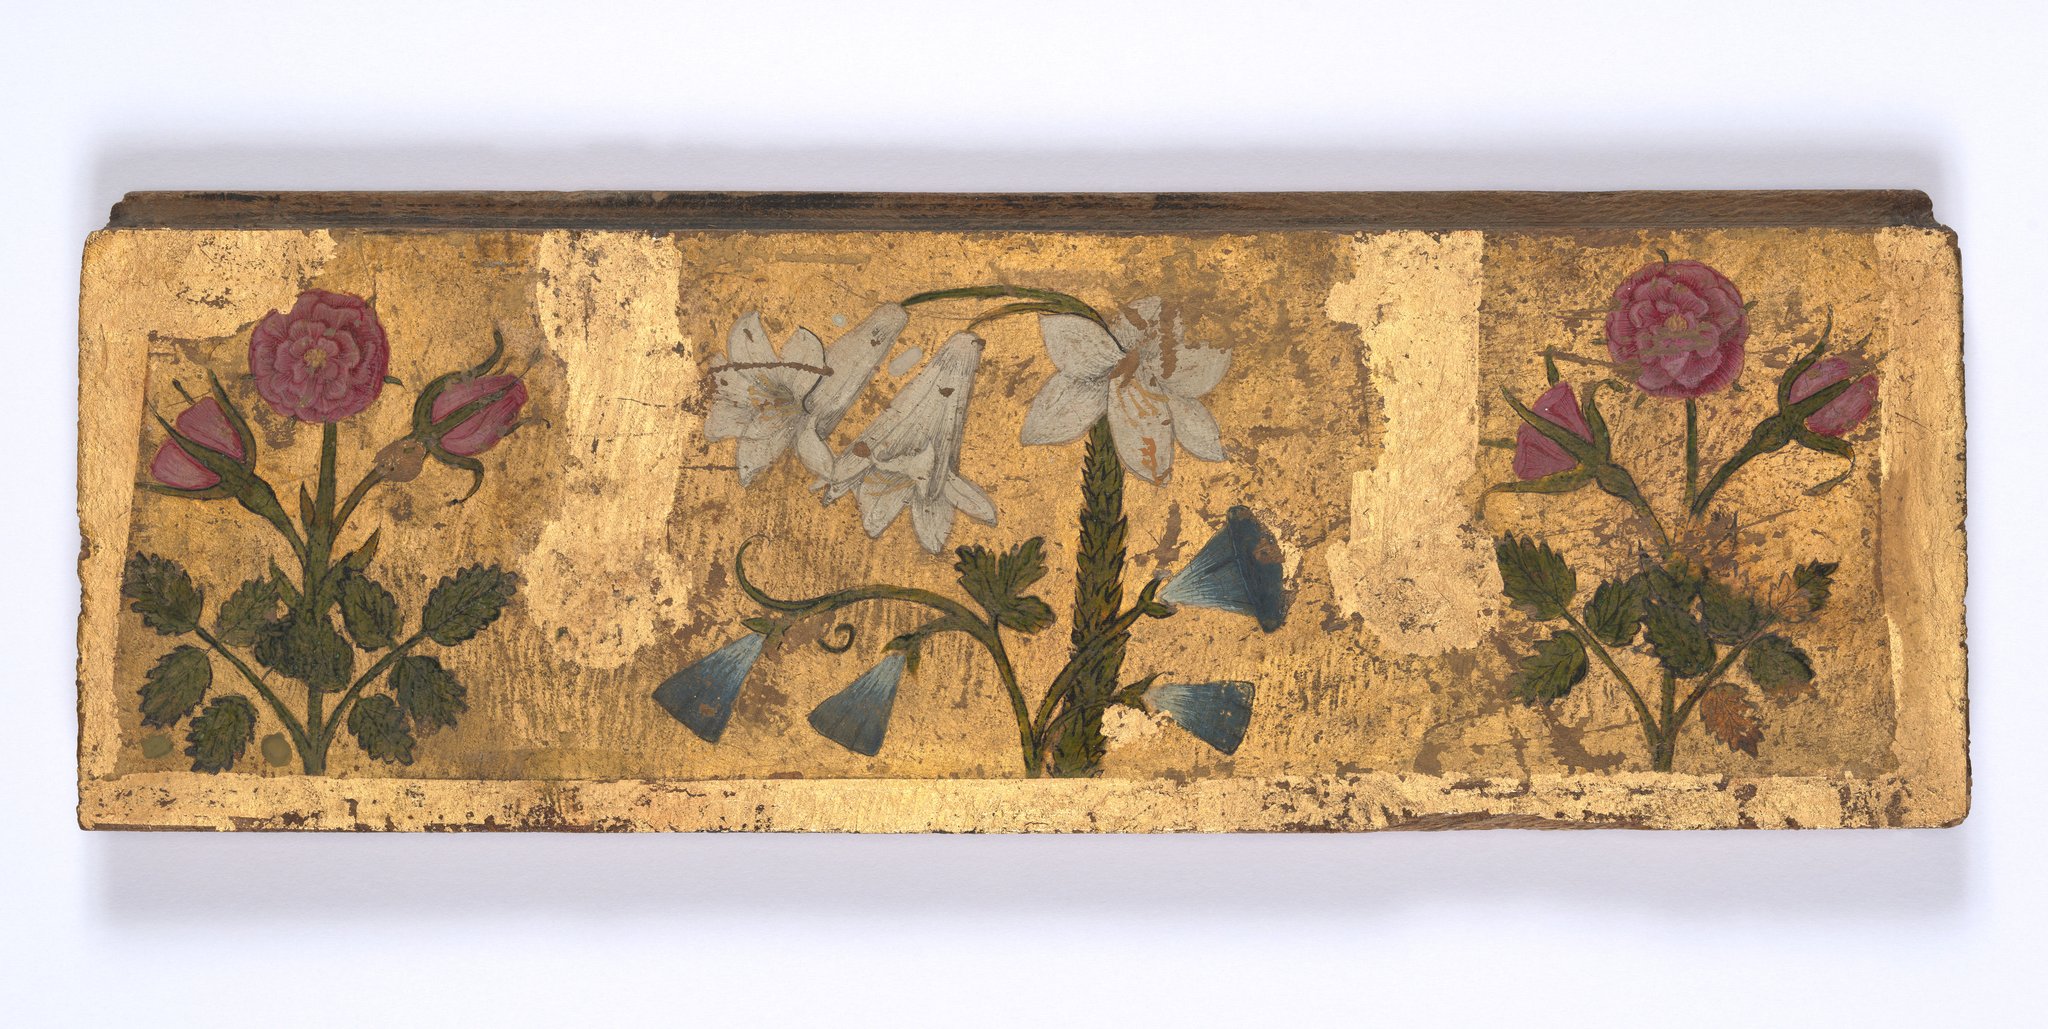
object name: painting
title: Two Panels with Flower Designs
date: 1650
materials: wood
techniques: lacquer, painting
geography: india